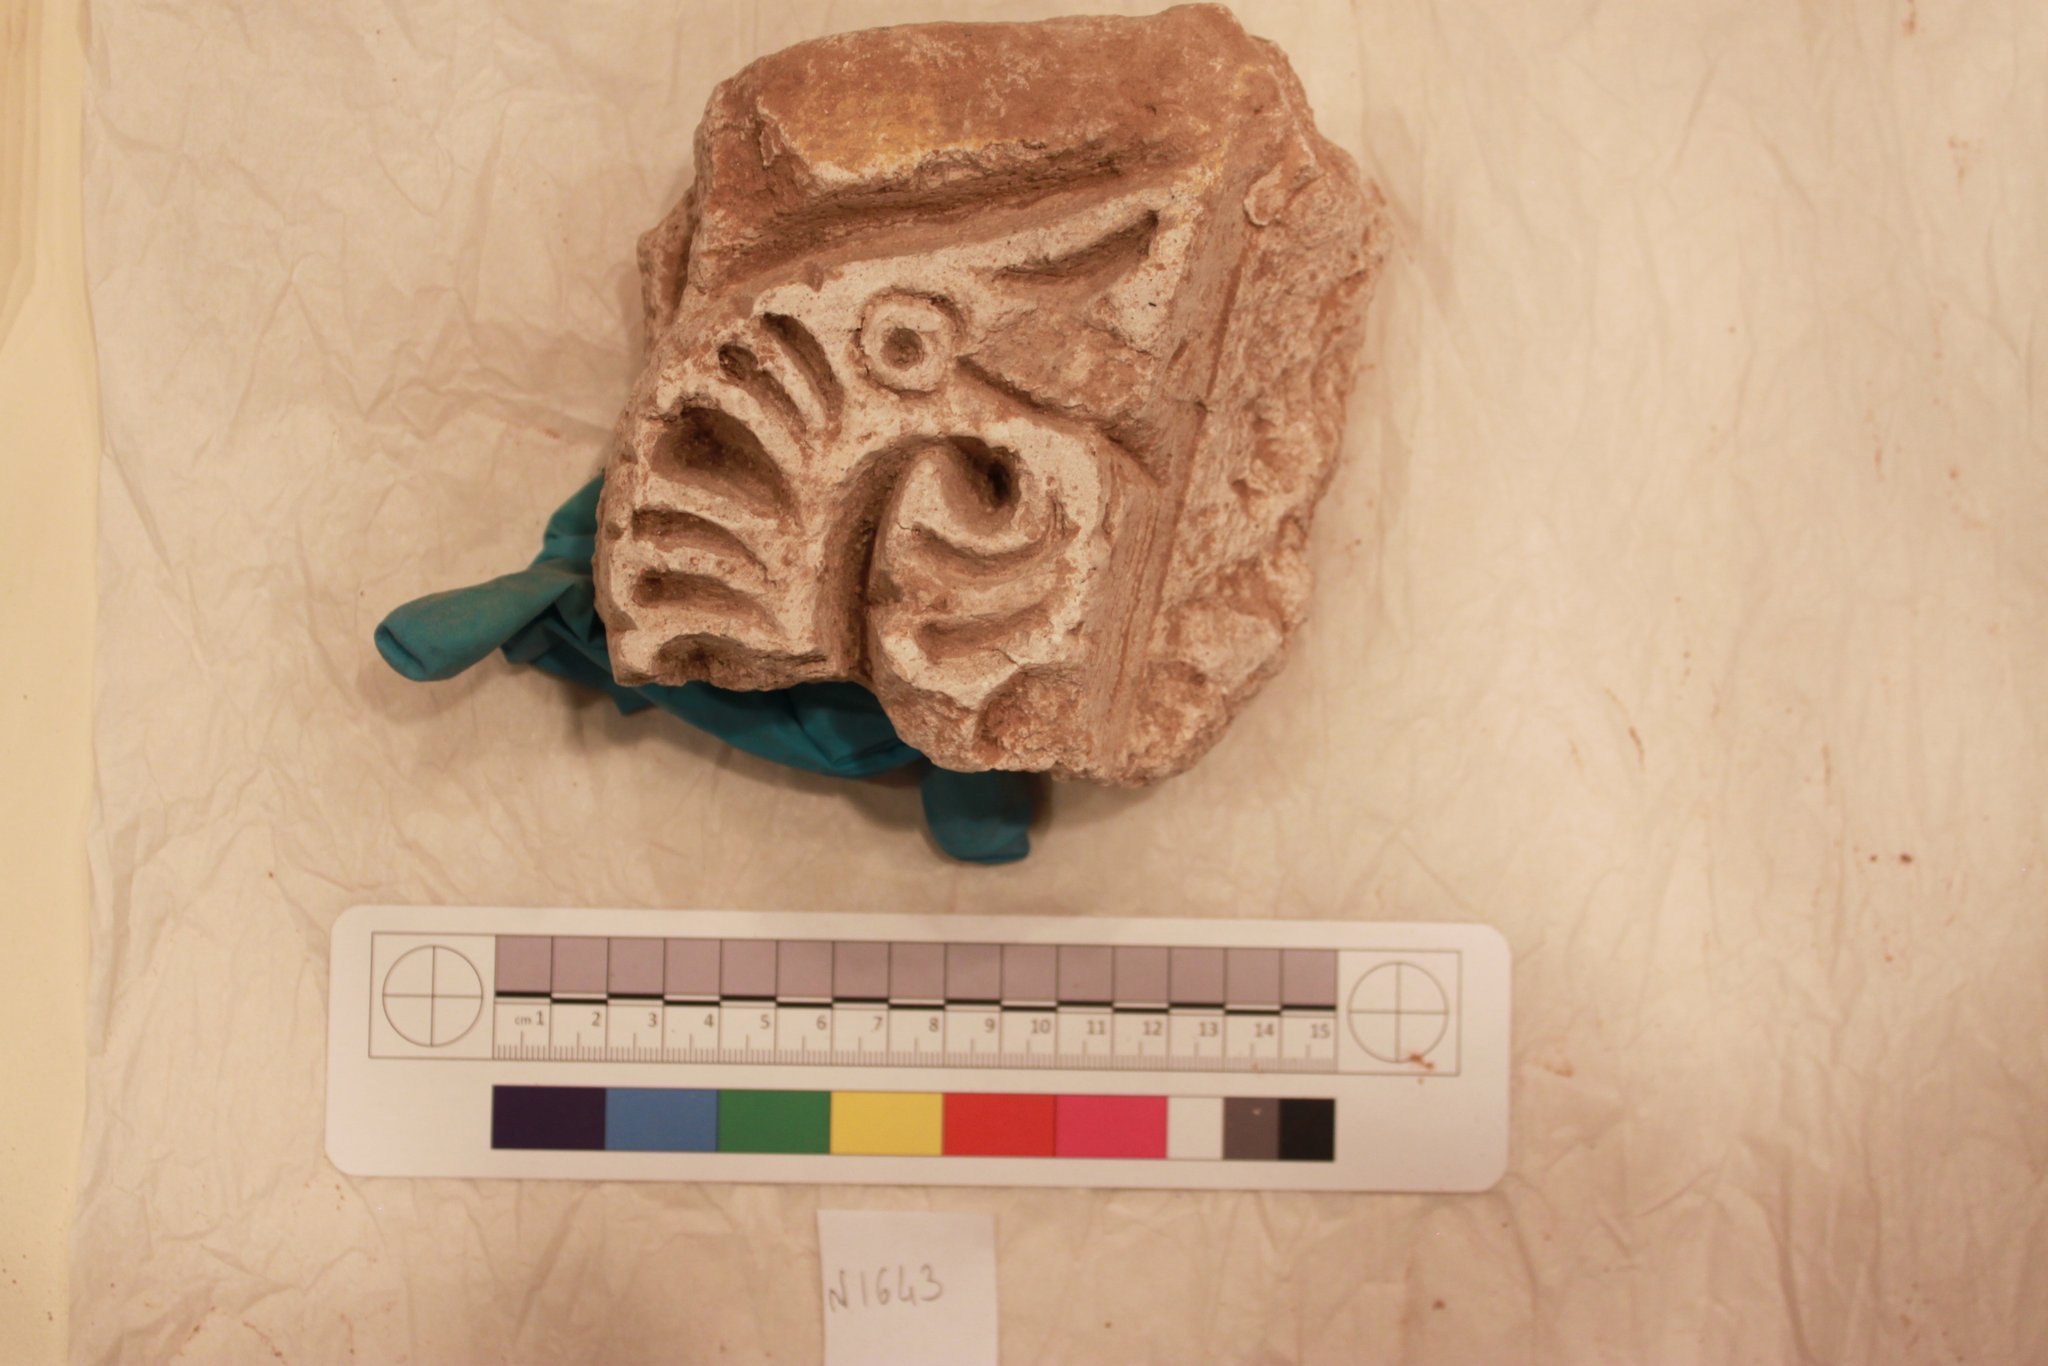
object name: fragment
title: Stucco Fragment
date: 701-1200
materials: plaster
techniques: carving, painting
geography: iran